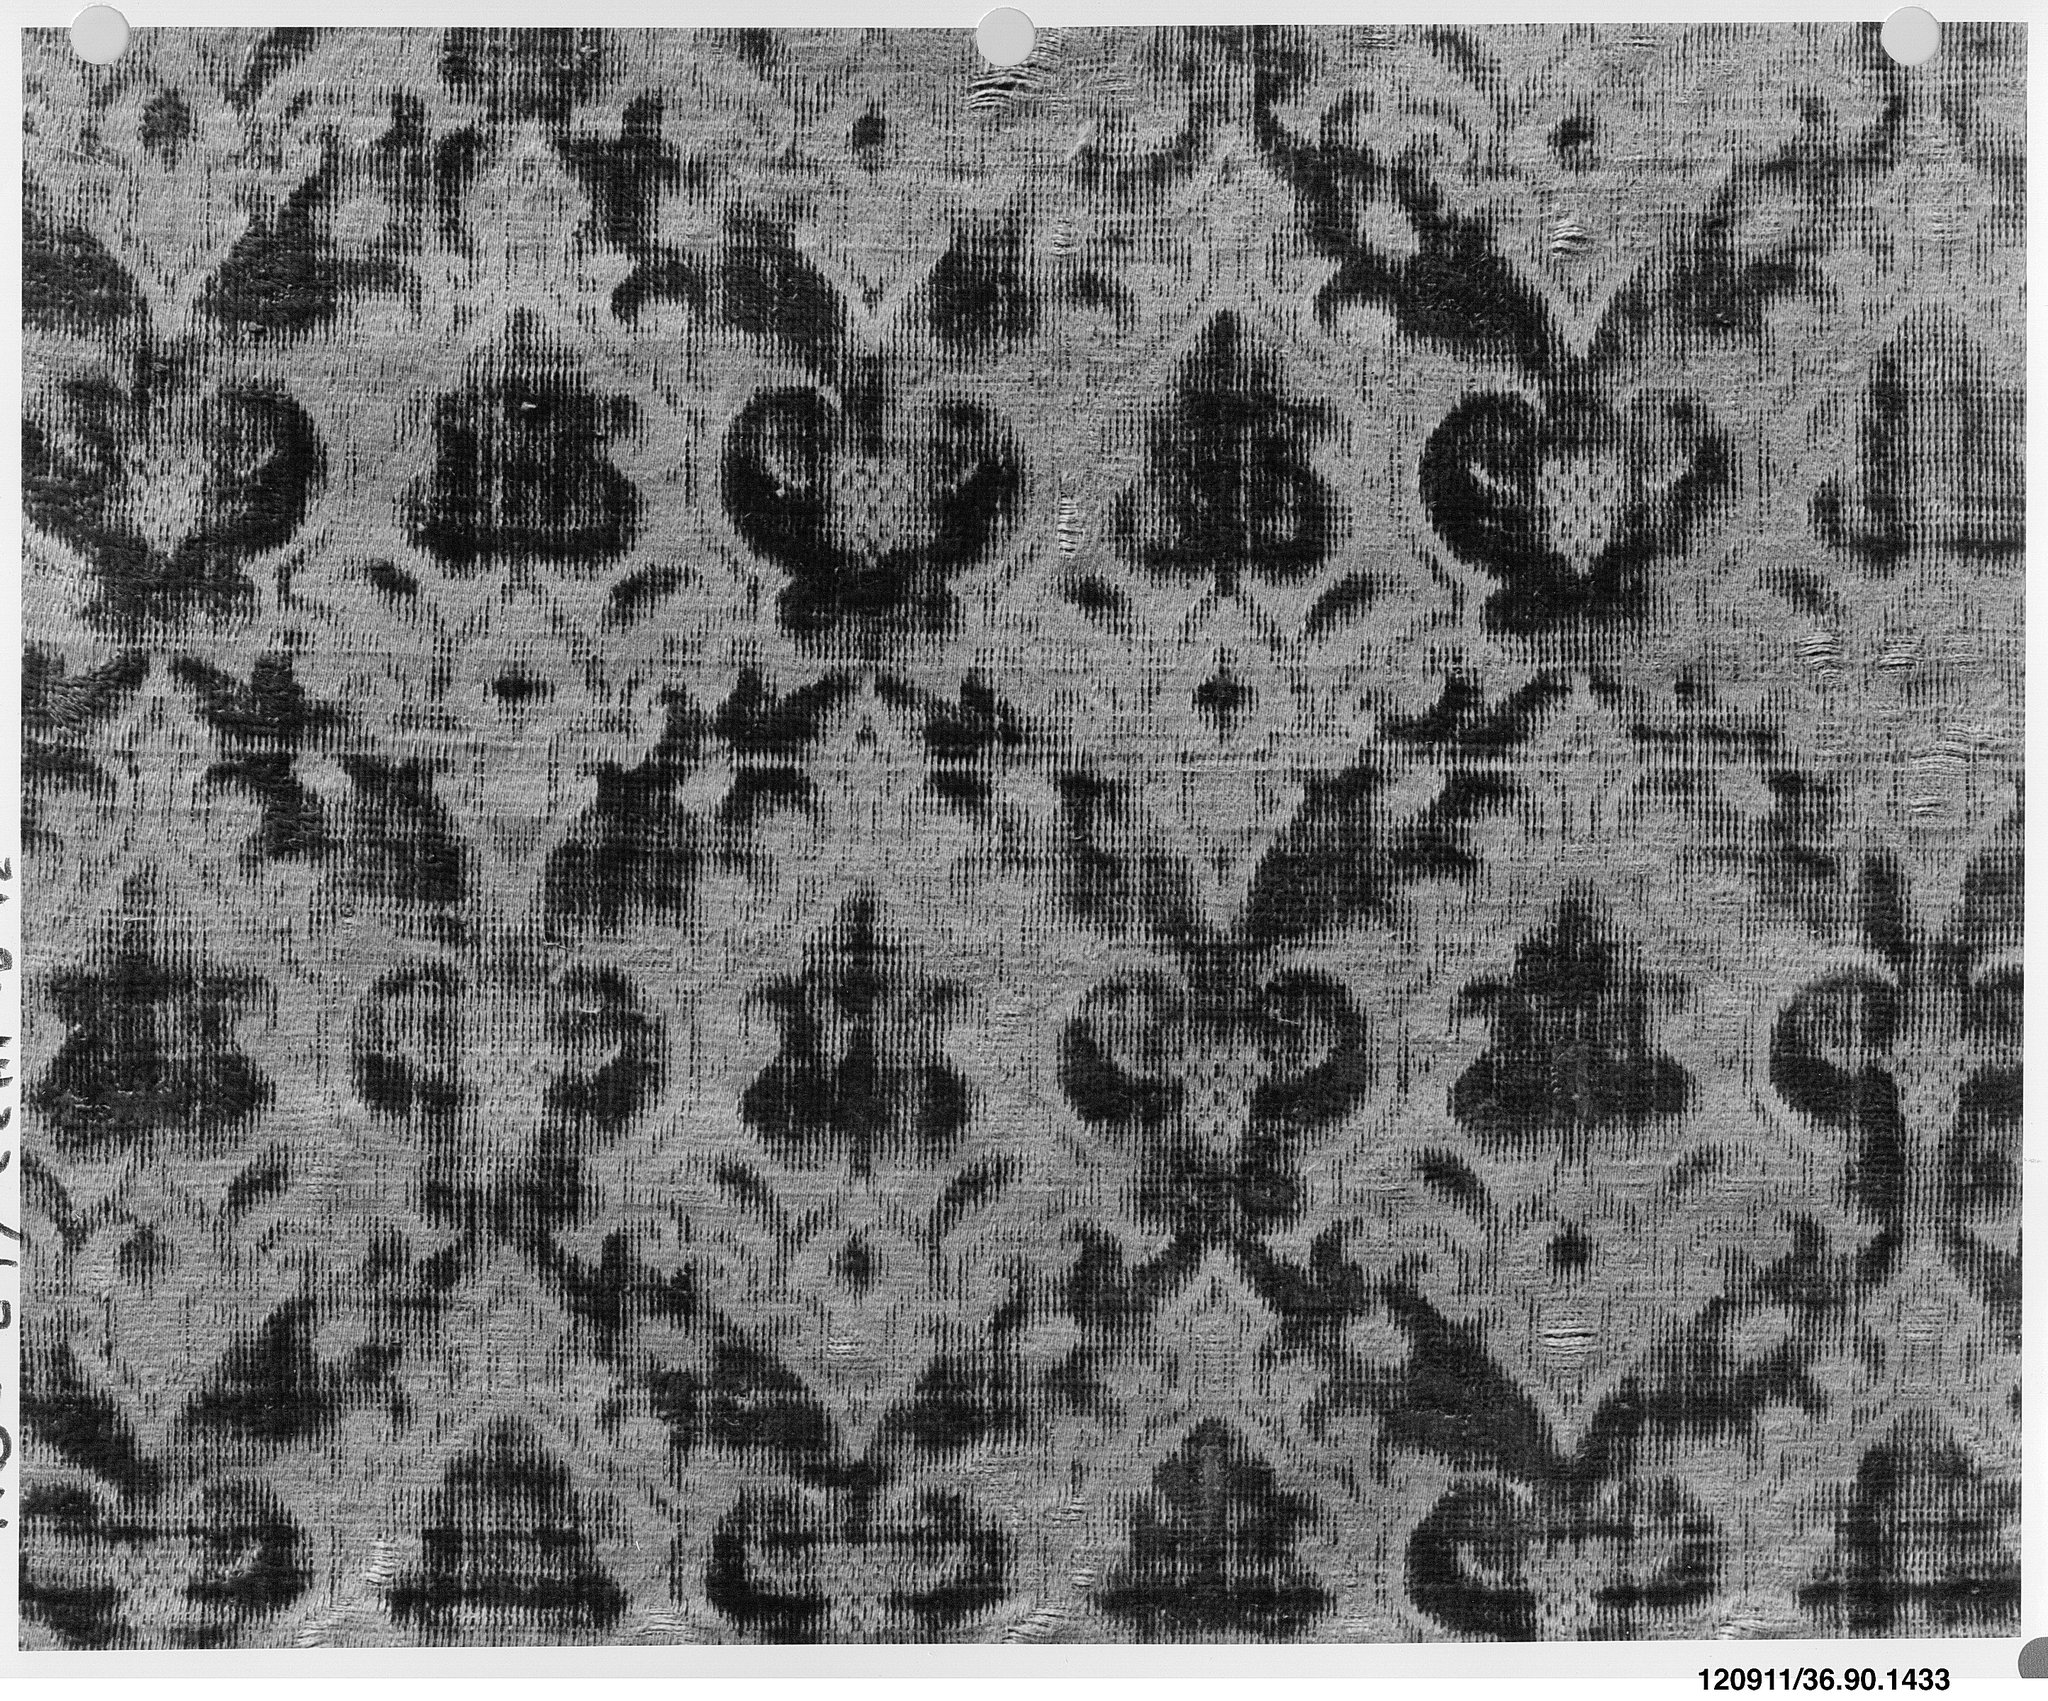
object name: piece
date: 1601-1700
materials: silk